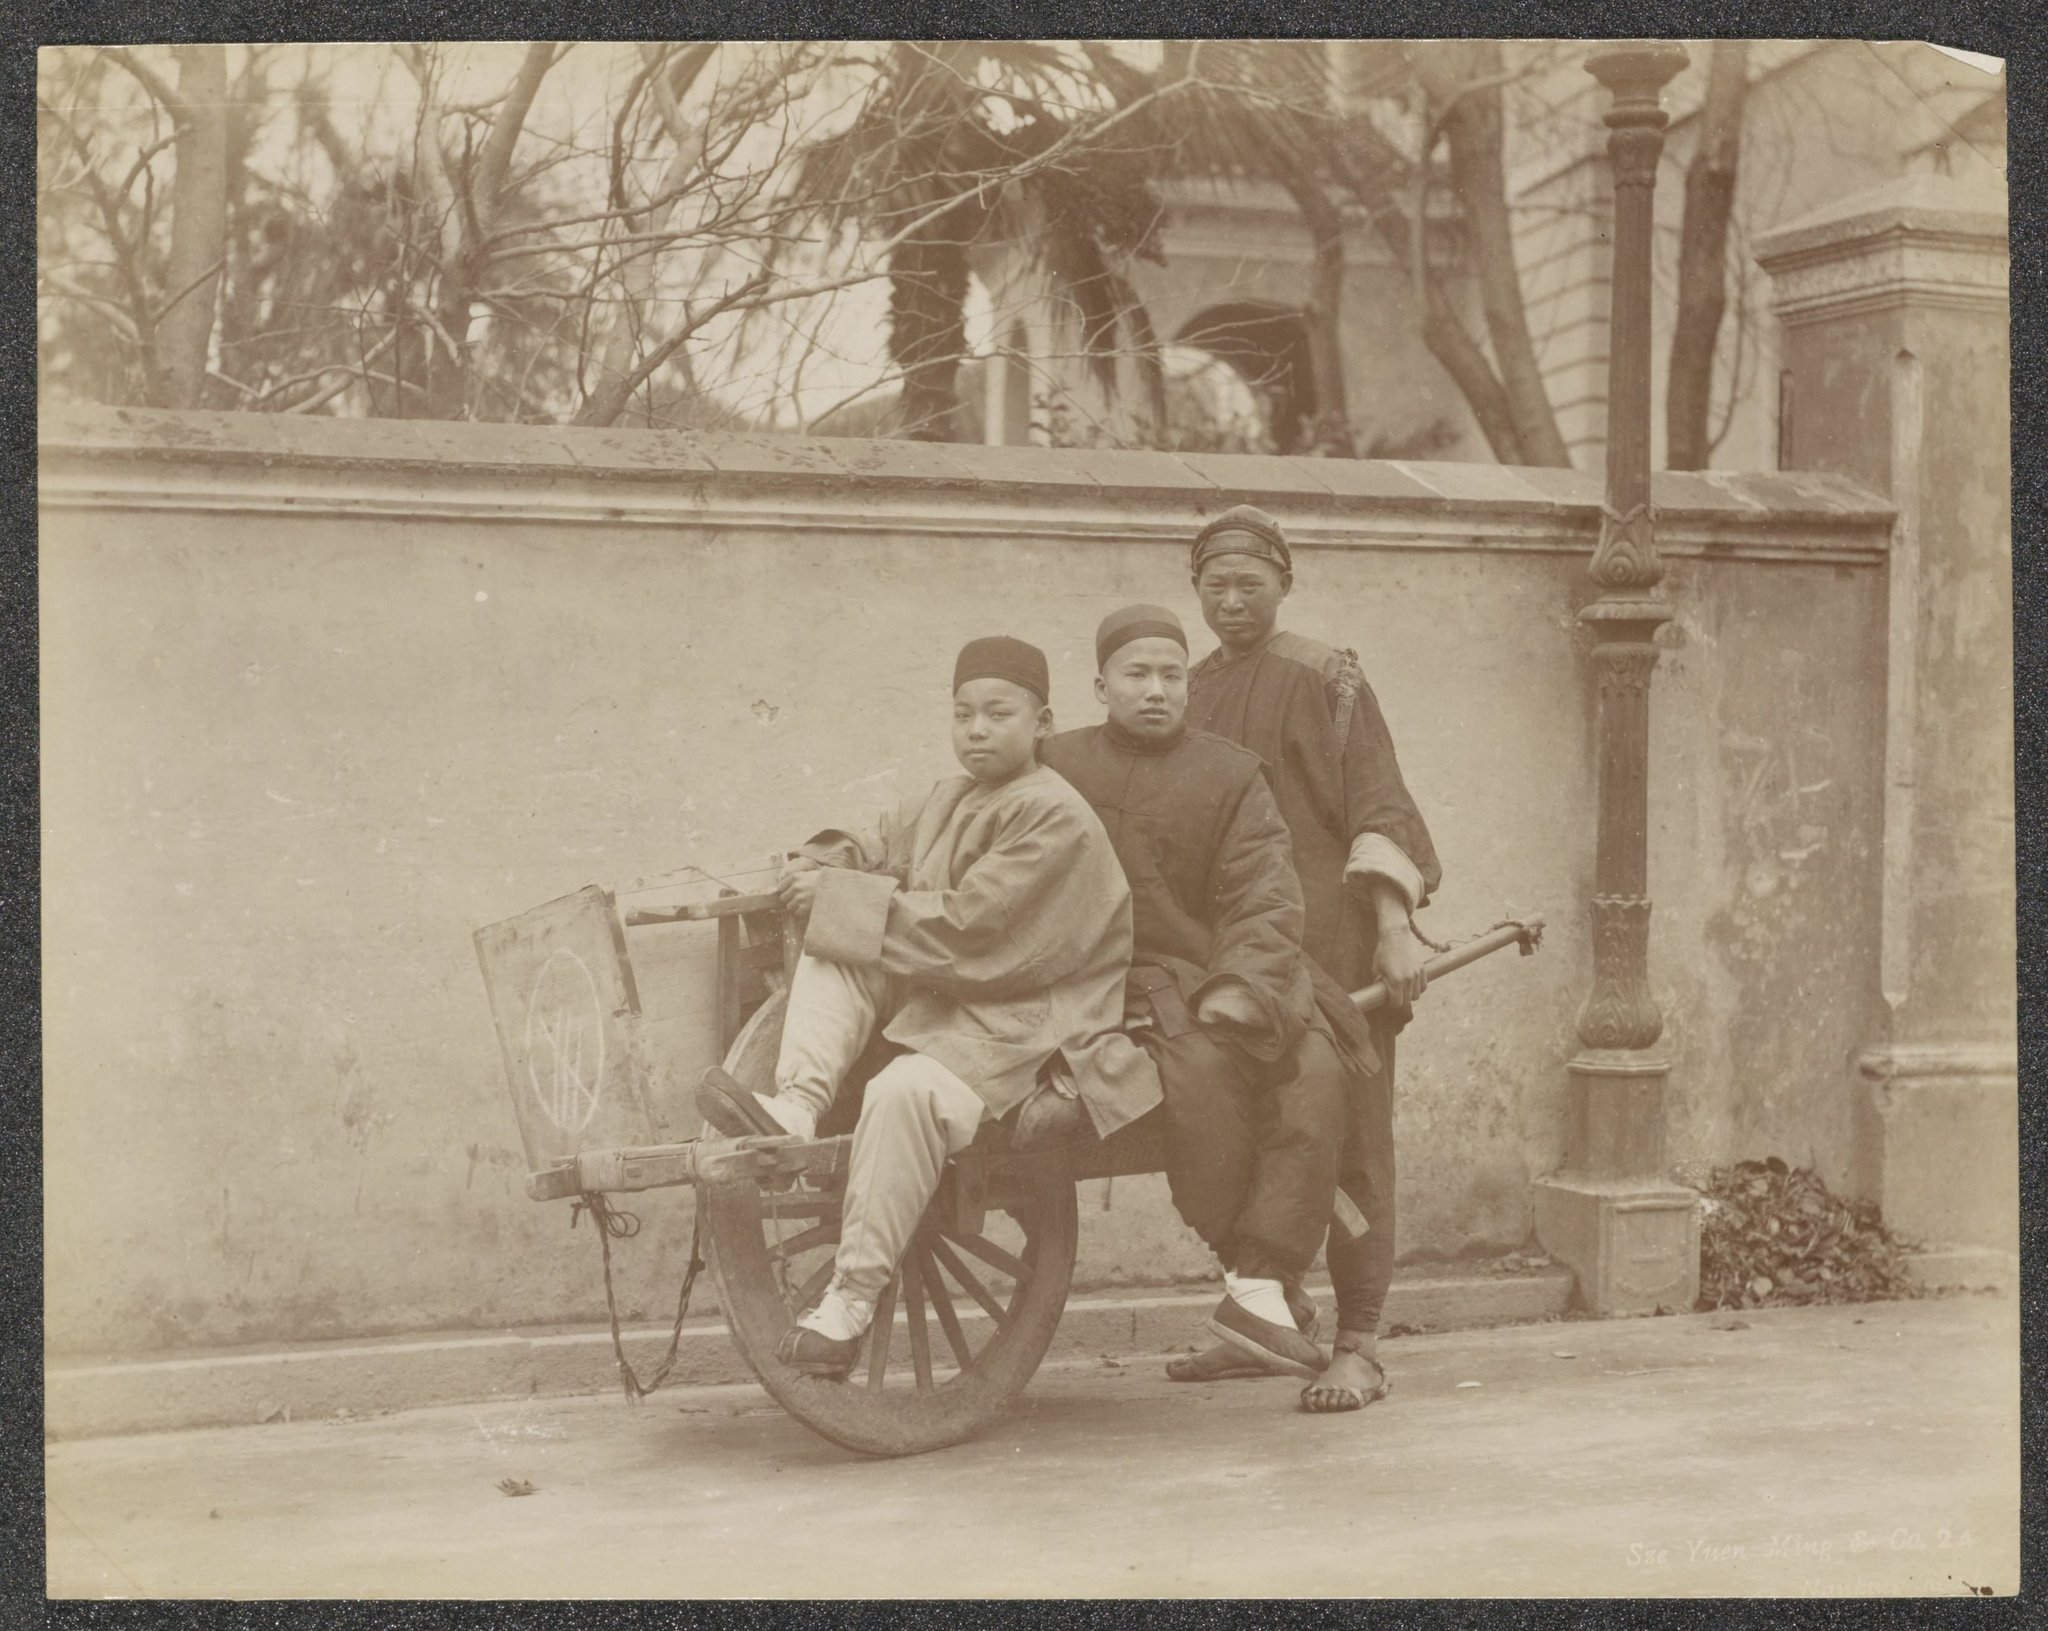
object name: album leaf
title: Drie Chinezen in Shanghai gebruiken kruiwagen als vervoermiddel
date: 1860-1900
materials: paper, photographic support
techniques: albumen print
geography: shanghai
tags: wheelbarrow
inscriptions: address: ‘42 Nanking Road’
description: Onderdeel van Album met 50 foto's van een reis door Zuidoost-Azië.